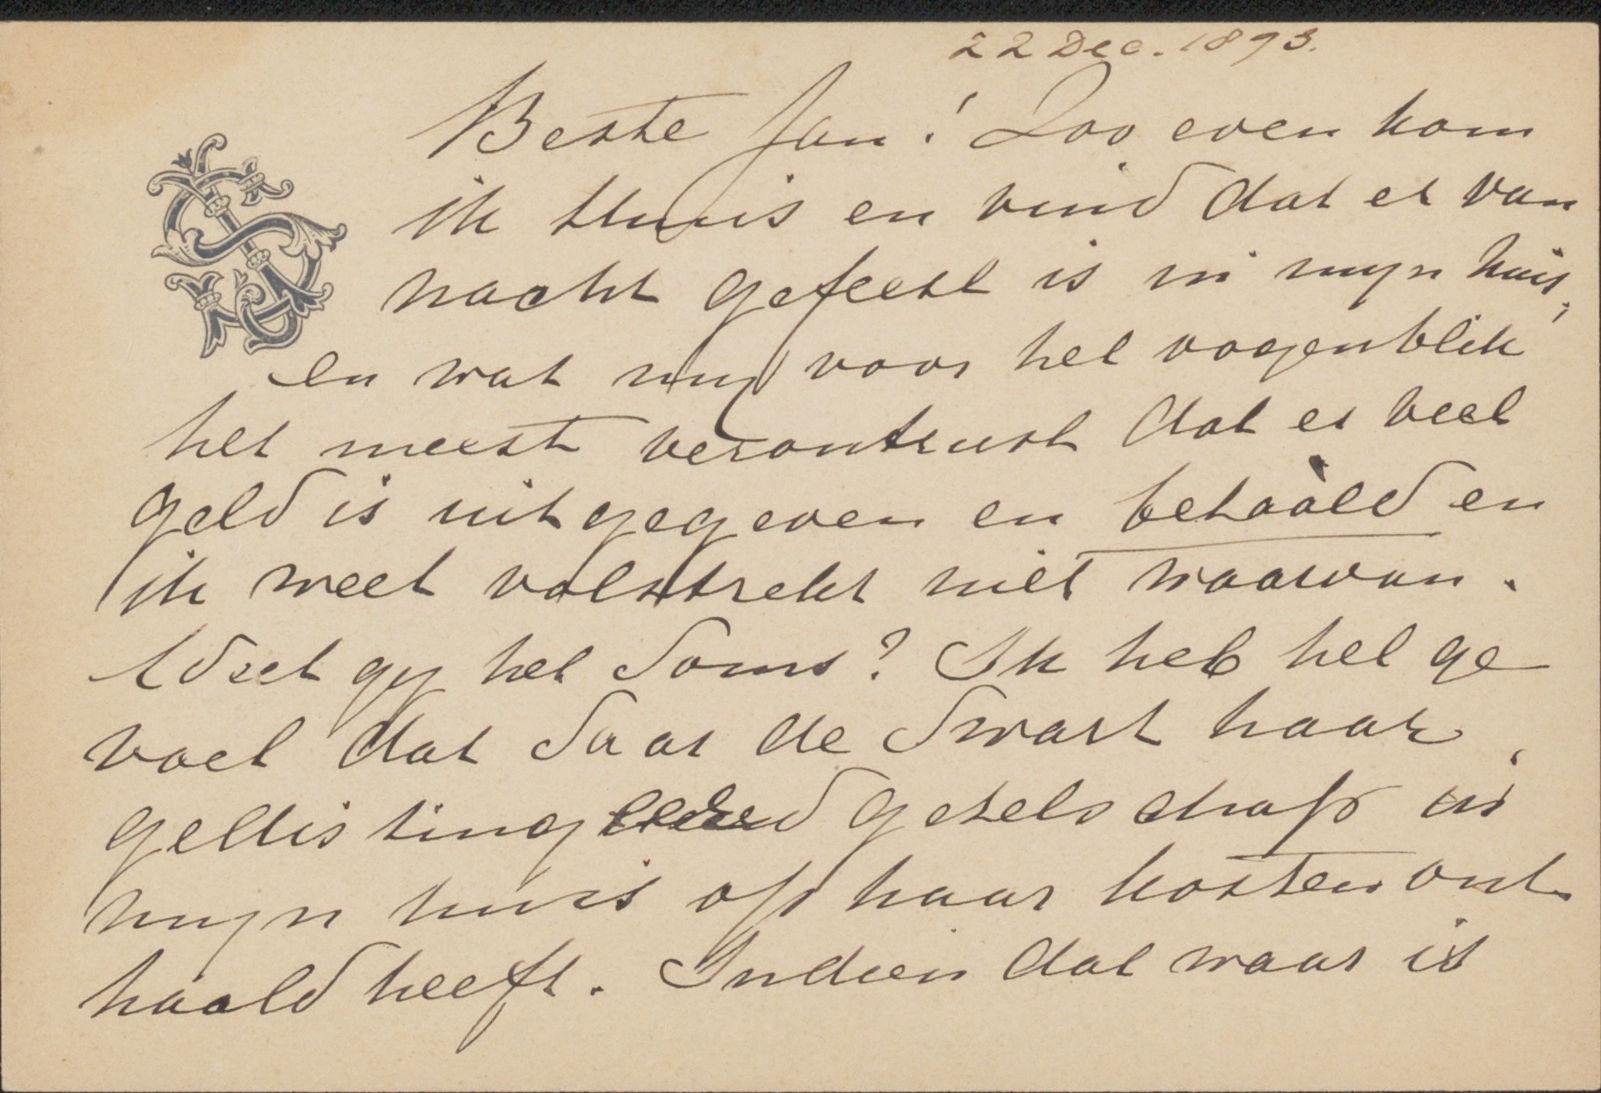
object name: letter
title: Brief aan Jan Veth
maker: jacoba cornelia jolles-singels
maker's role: schrijver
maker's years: 1847-1901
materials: cardboard, ink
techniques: pen, writing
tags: dordrecht, amsterdam, painter, draughtsman, designer, jan veth, arnhem, saar de swart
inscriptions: monogram: ‘JS’, collector's mark: ‘RPK’